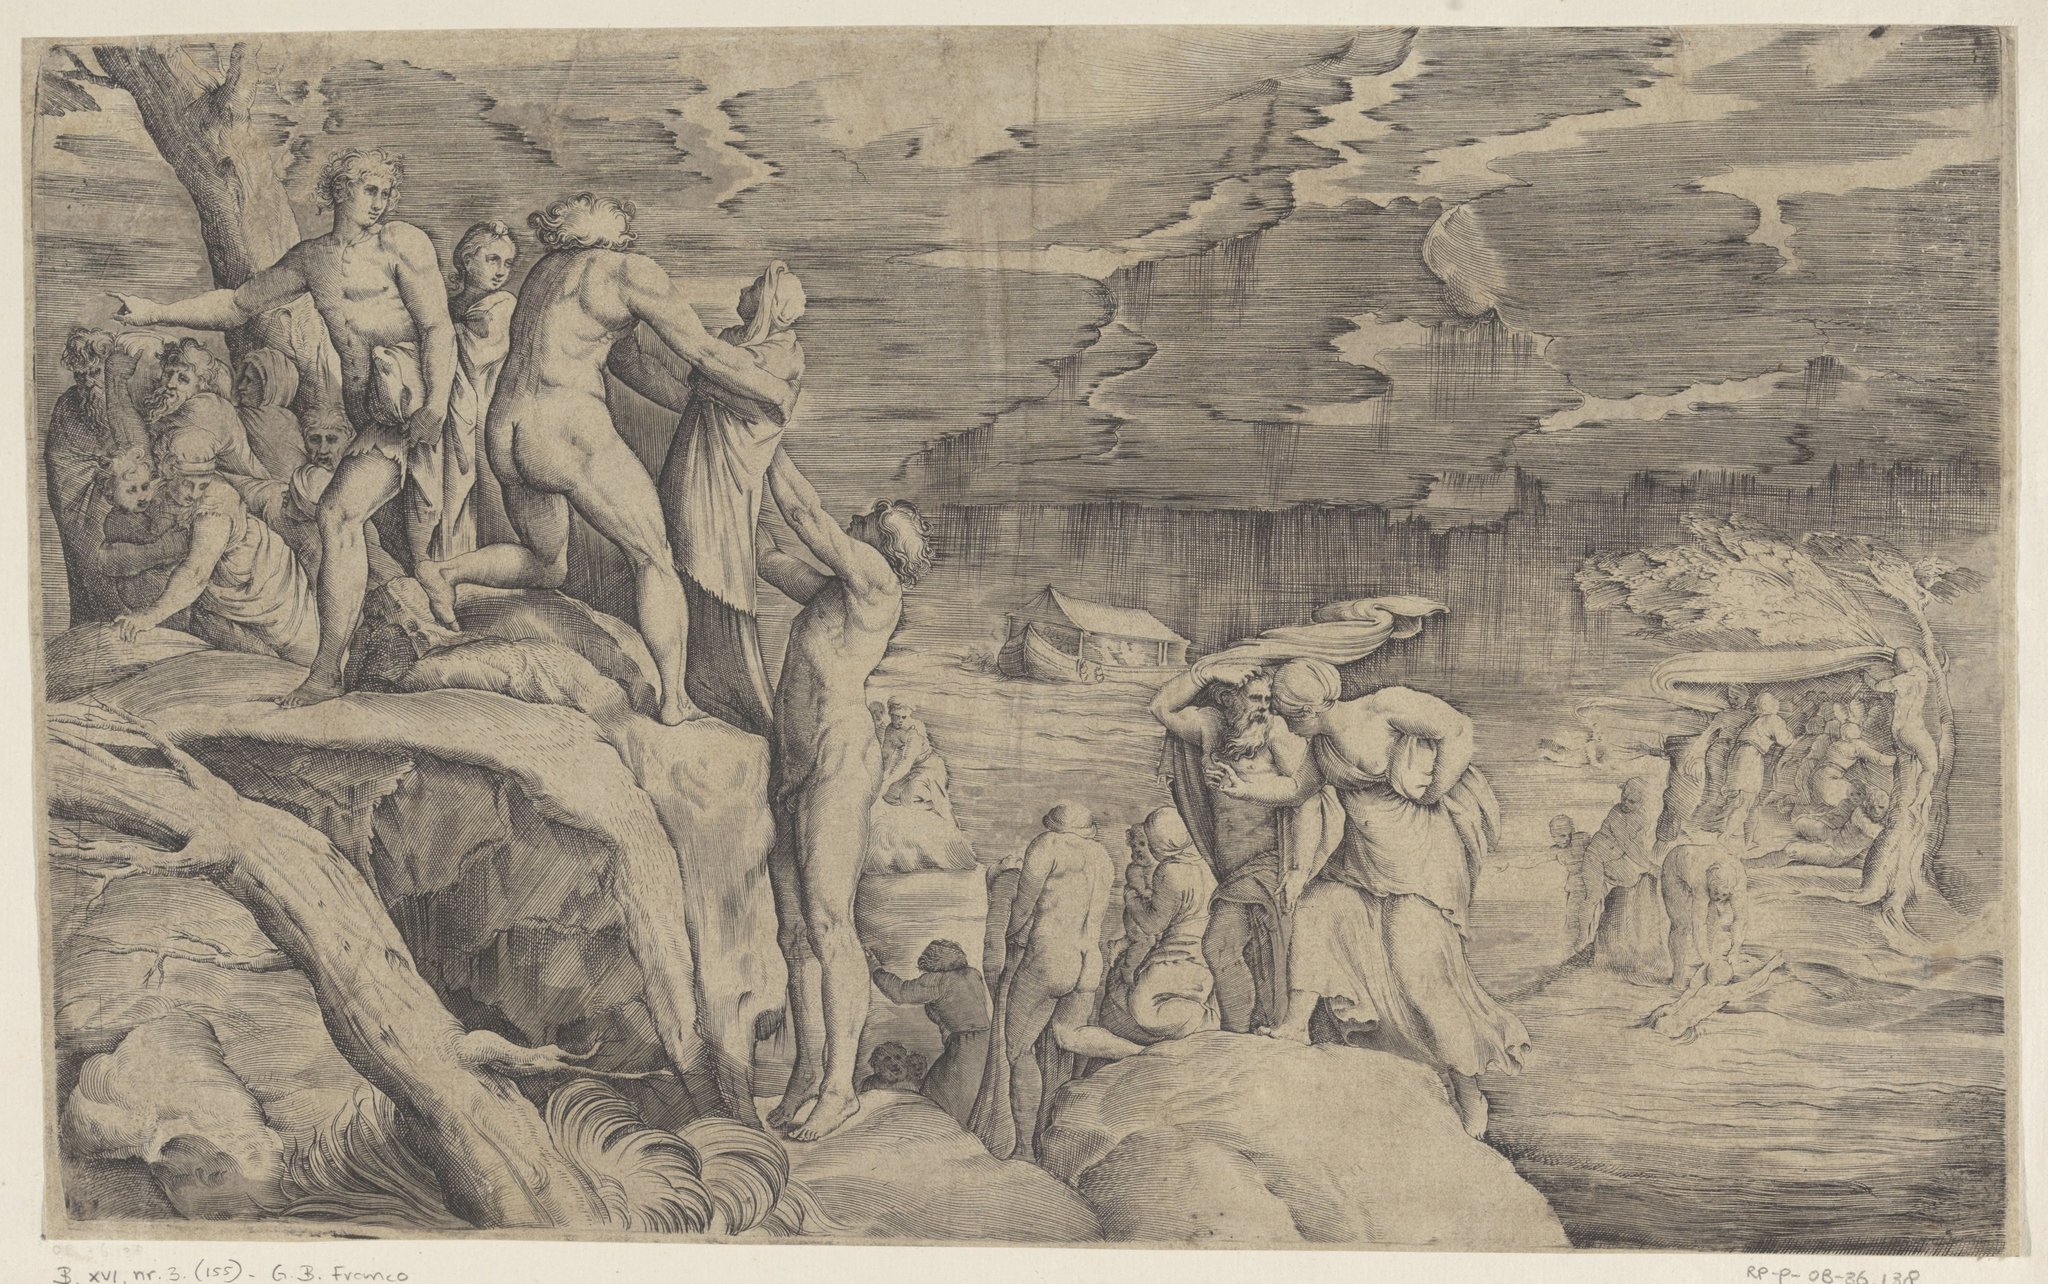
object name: print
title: De Zondvloed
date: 1520-1561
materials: paper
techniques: colour, engraving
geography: italy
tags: the flood and destruction of mankind ~ story of noah (genesis 7:10 - 8:17)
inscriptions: collector's mark: Lugt 240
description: De Zondvloed. Mensen vluchten voor het stijgende water. Op de achtergrond de Ark van Noach.